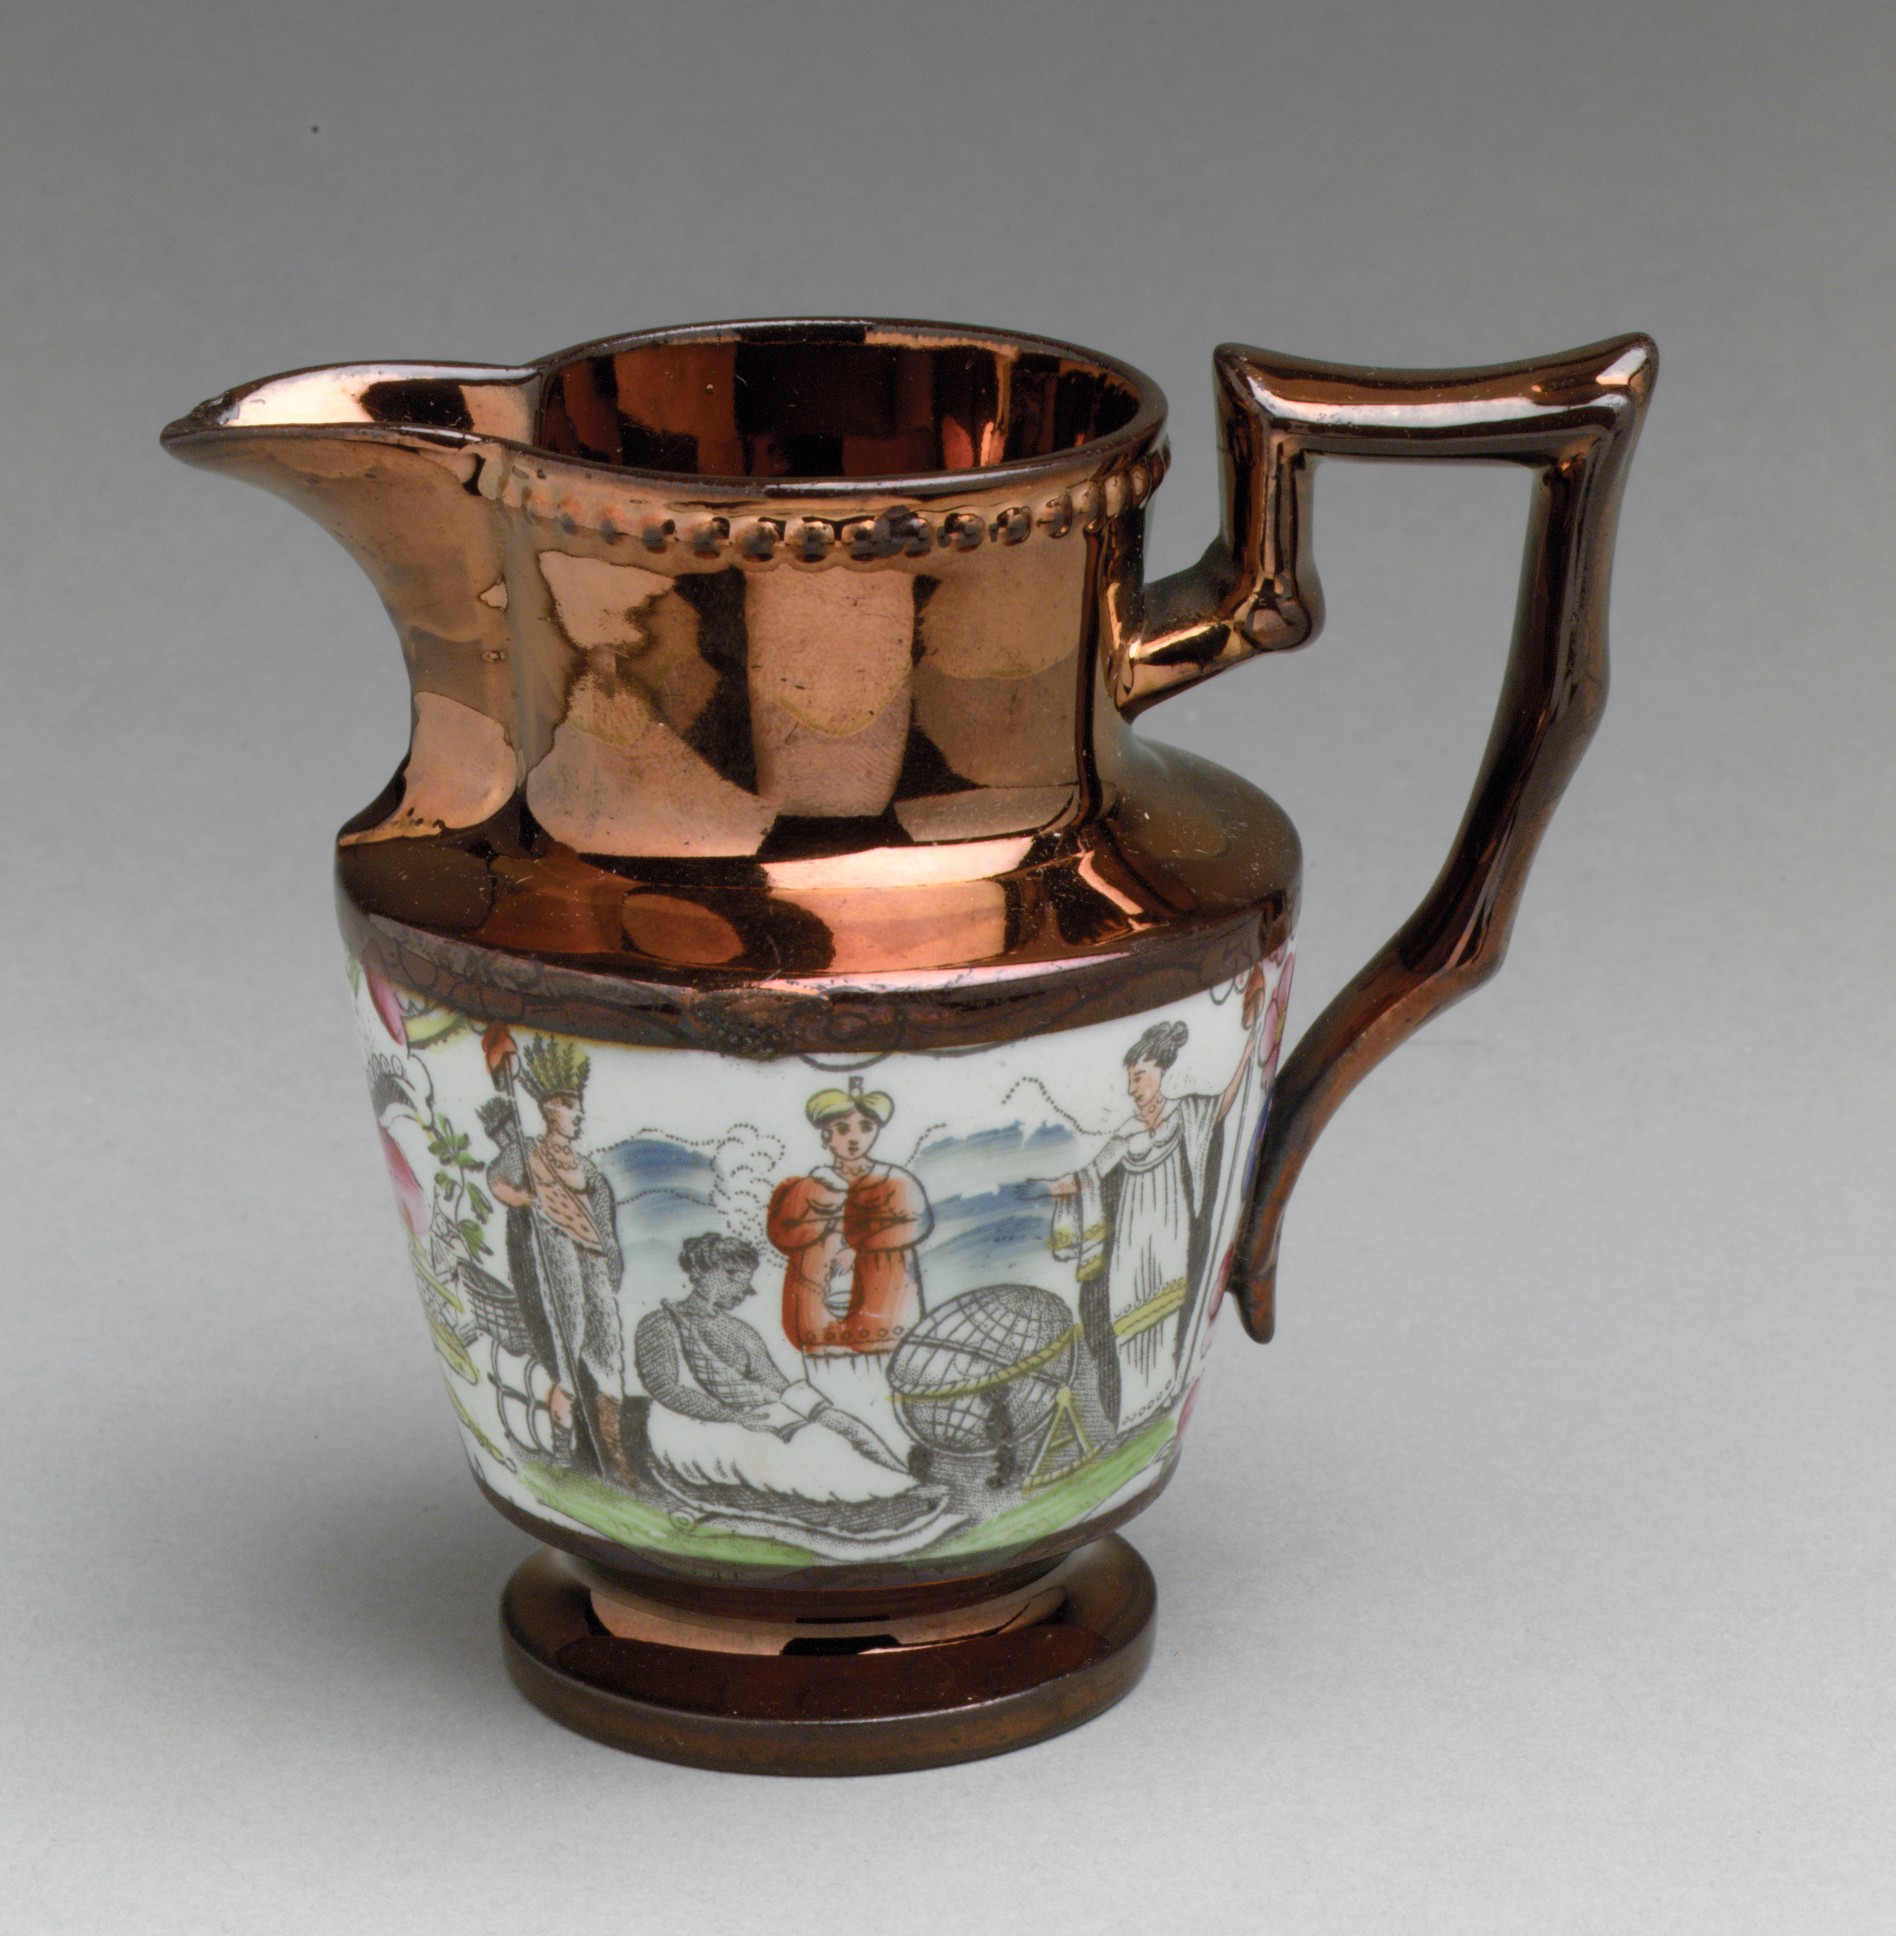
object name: jug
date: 1801-1900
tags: men,women